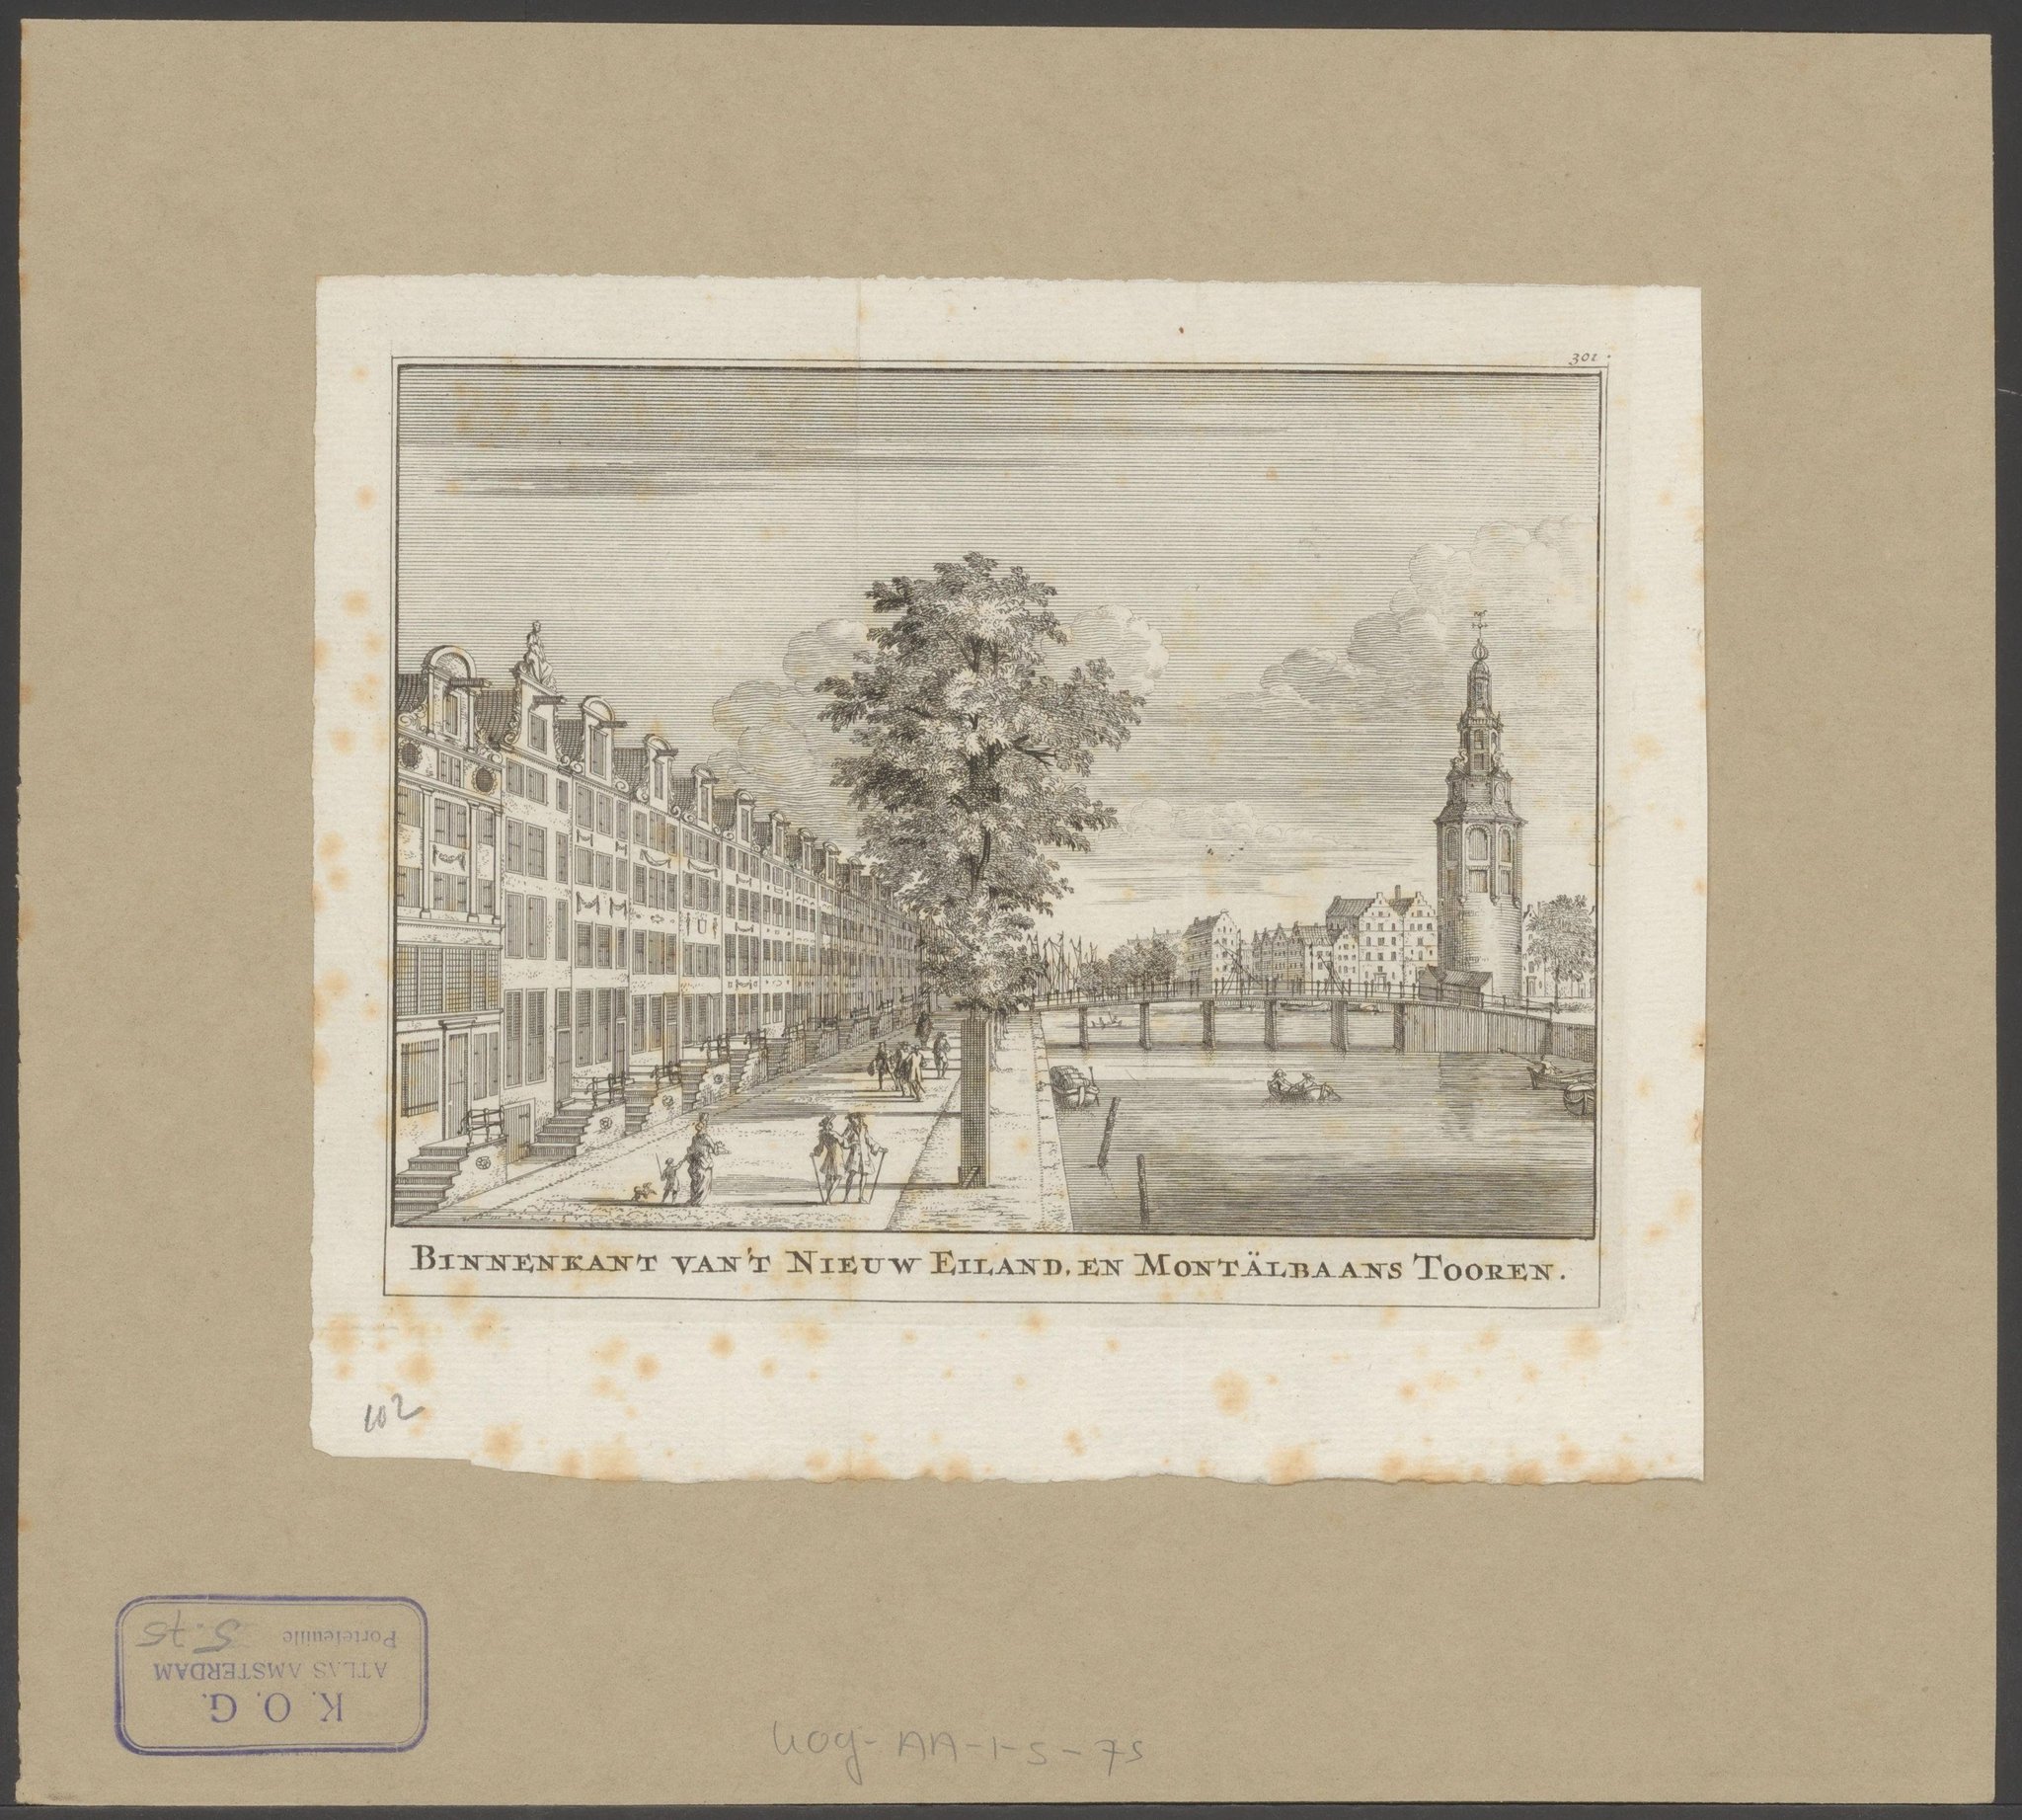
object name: print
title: Binnenkant van 't Nieuw Eiland, en Montälbaans Tooren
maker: Anonymous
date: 1726-1751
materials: paper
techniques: etching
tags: tower, clock tower ~ monumental adornment, city-view in general; 'veduta', canal, bridge in city across river, canal, etc., boat propelled by man or animal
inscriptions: collector's mark: ‘5.75’ Lugt 1641b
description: Prent waarschijnlijk uit: Hoorn, Nicolaas ten. Wegwyzer door Amsterdam, Zynde eene beknopte verhandeling van desselfs eerste opkomst, vergrootingen, en teegenwoordigen staat (…). Amsterdam: Nicolaas ten Hoorn, 1726. Of uit: Hoorn, Nicolaas ten. Wegwyzer, of korte beschryvinge Van de Stadt Amsterdam, Zynde eene beknopte Verhandeling van desselfs eerste opkomst, vergrootingen, en tegenwoordigen staat (…). Amsterdam: erven J. Ratelband & Co, 1737. Of uit: Hoorn, Nicolaas ten. Wegwyzer of korte beschryvinge der stad Amsterdam. Zynde eene Beknopte Verhandeling van derzelver eerste Opkomst, Vergrootingen en Tegenwoordigen Staat (…). Amsterdam: Pieter Meyer, 1751. Eerste bekende staat (rechtsboven genummerd '282') ook gebruikt in: Hoorn, Nicolaas ten. Wegwyzer door Amsterdam, Zynde eene beknopte verhandeling van desselfs eerste opkomst, vergrootingen, en teegenwoordigen staat (…). Amsterdam: Nicolaas ten Hoorn, 1713. Op de derde bekende staat is rechtsboven de nummering '301' zichtbaar uitgewist.